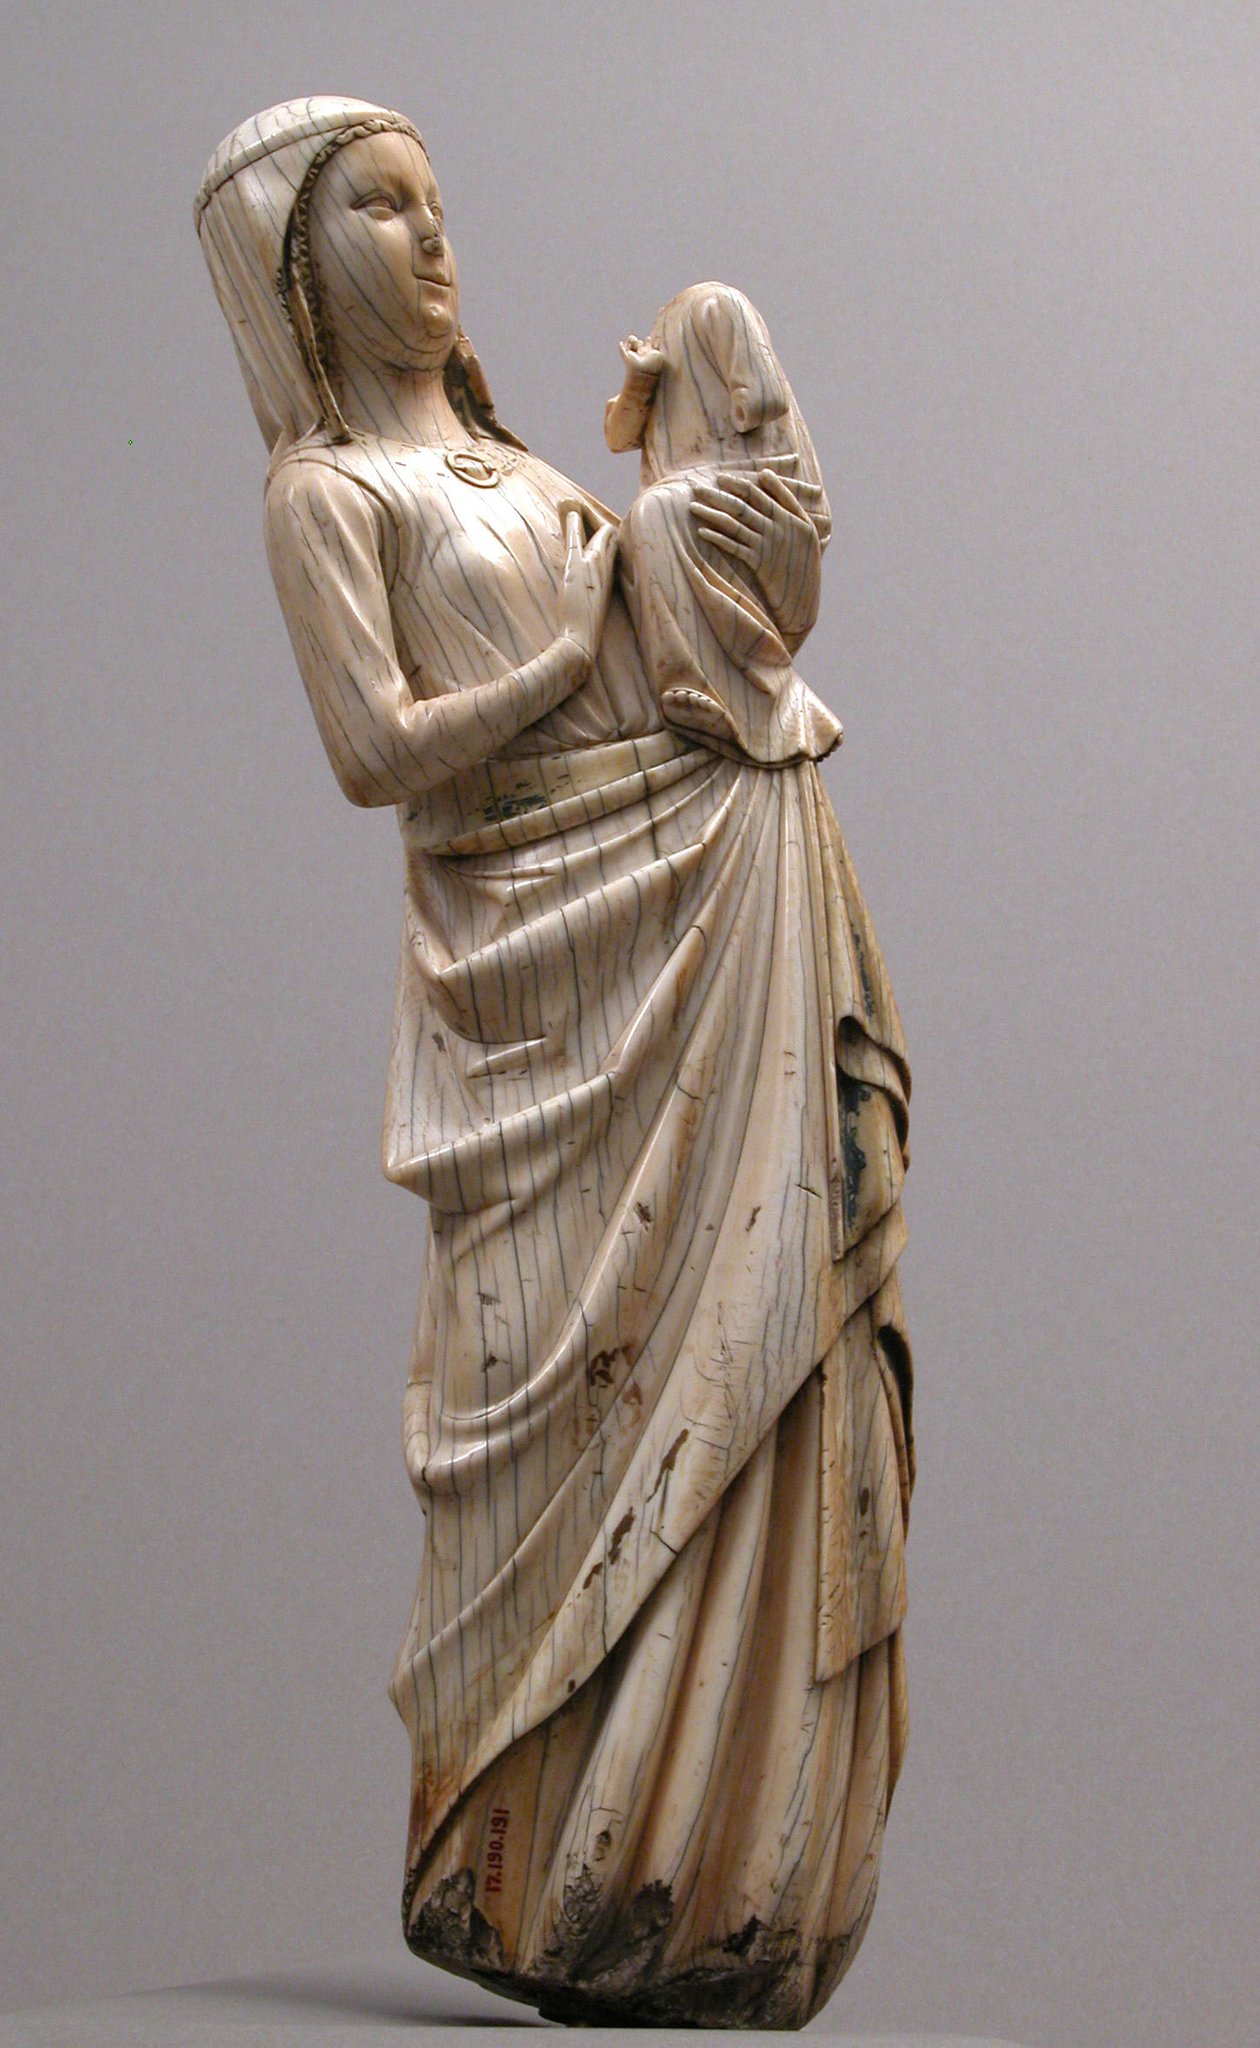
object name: statuette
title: Virgin and Child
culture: french, north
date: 1250-1275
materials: ivory, paint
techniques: gilding